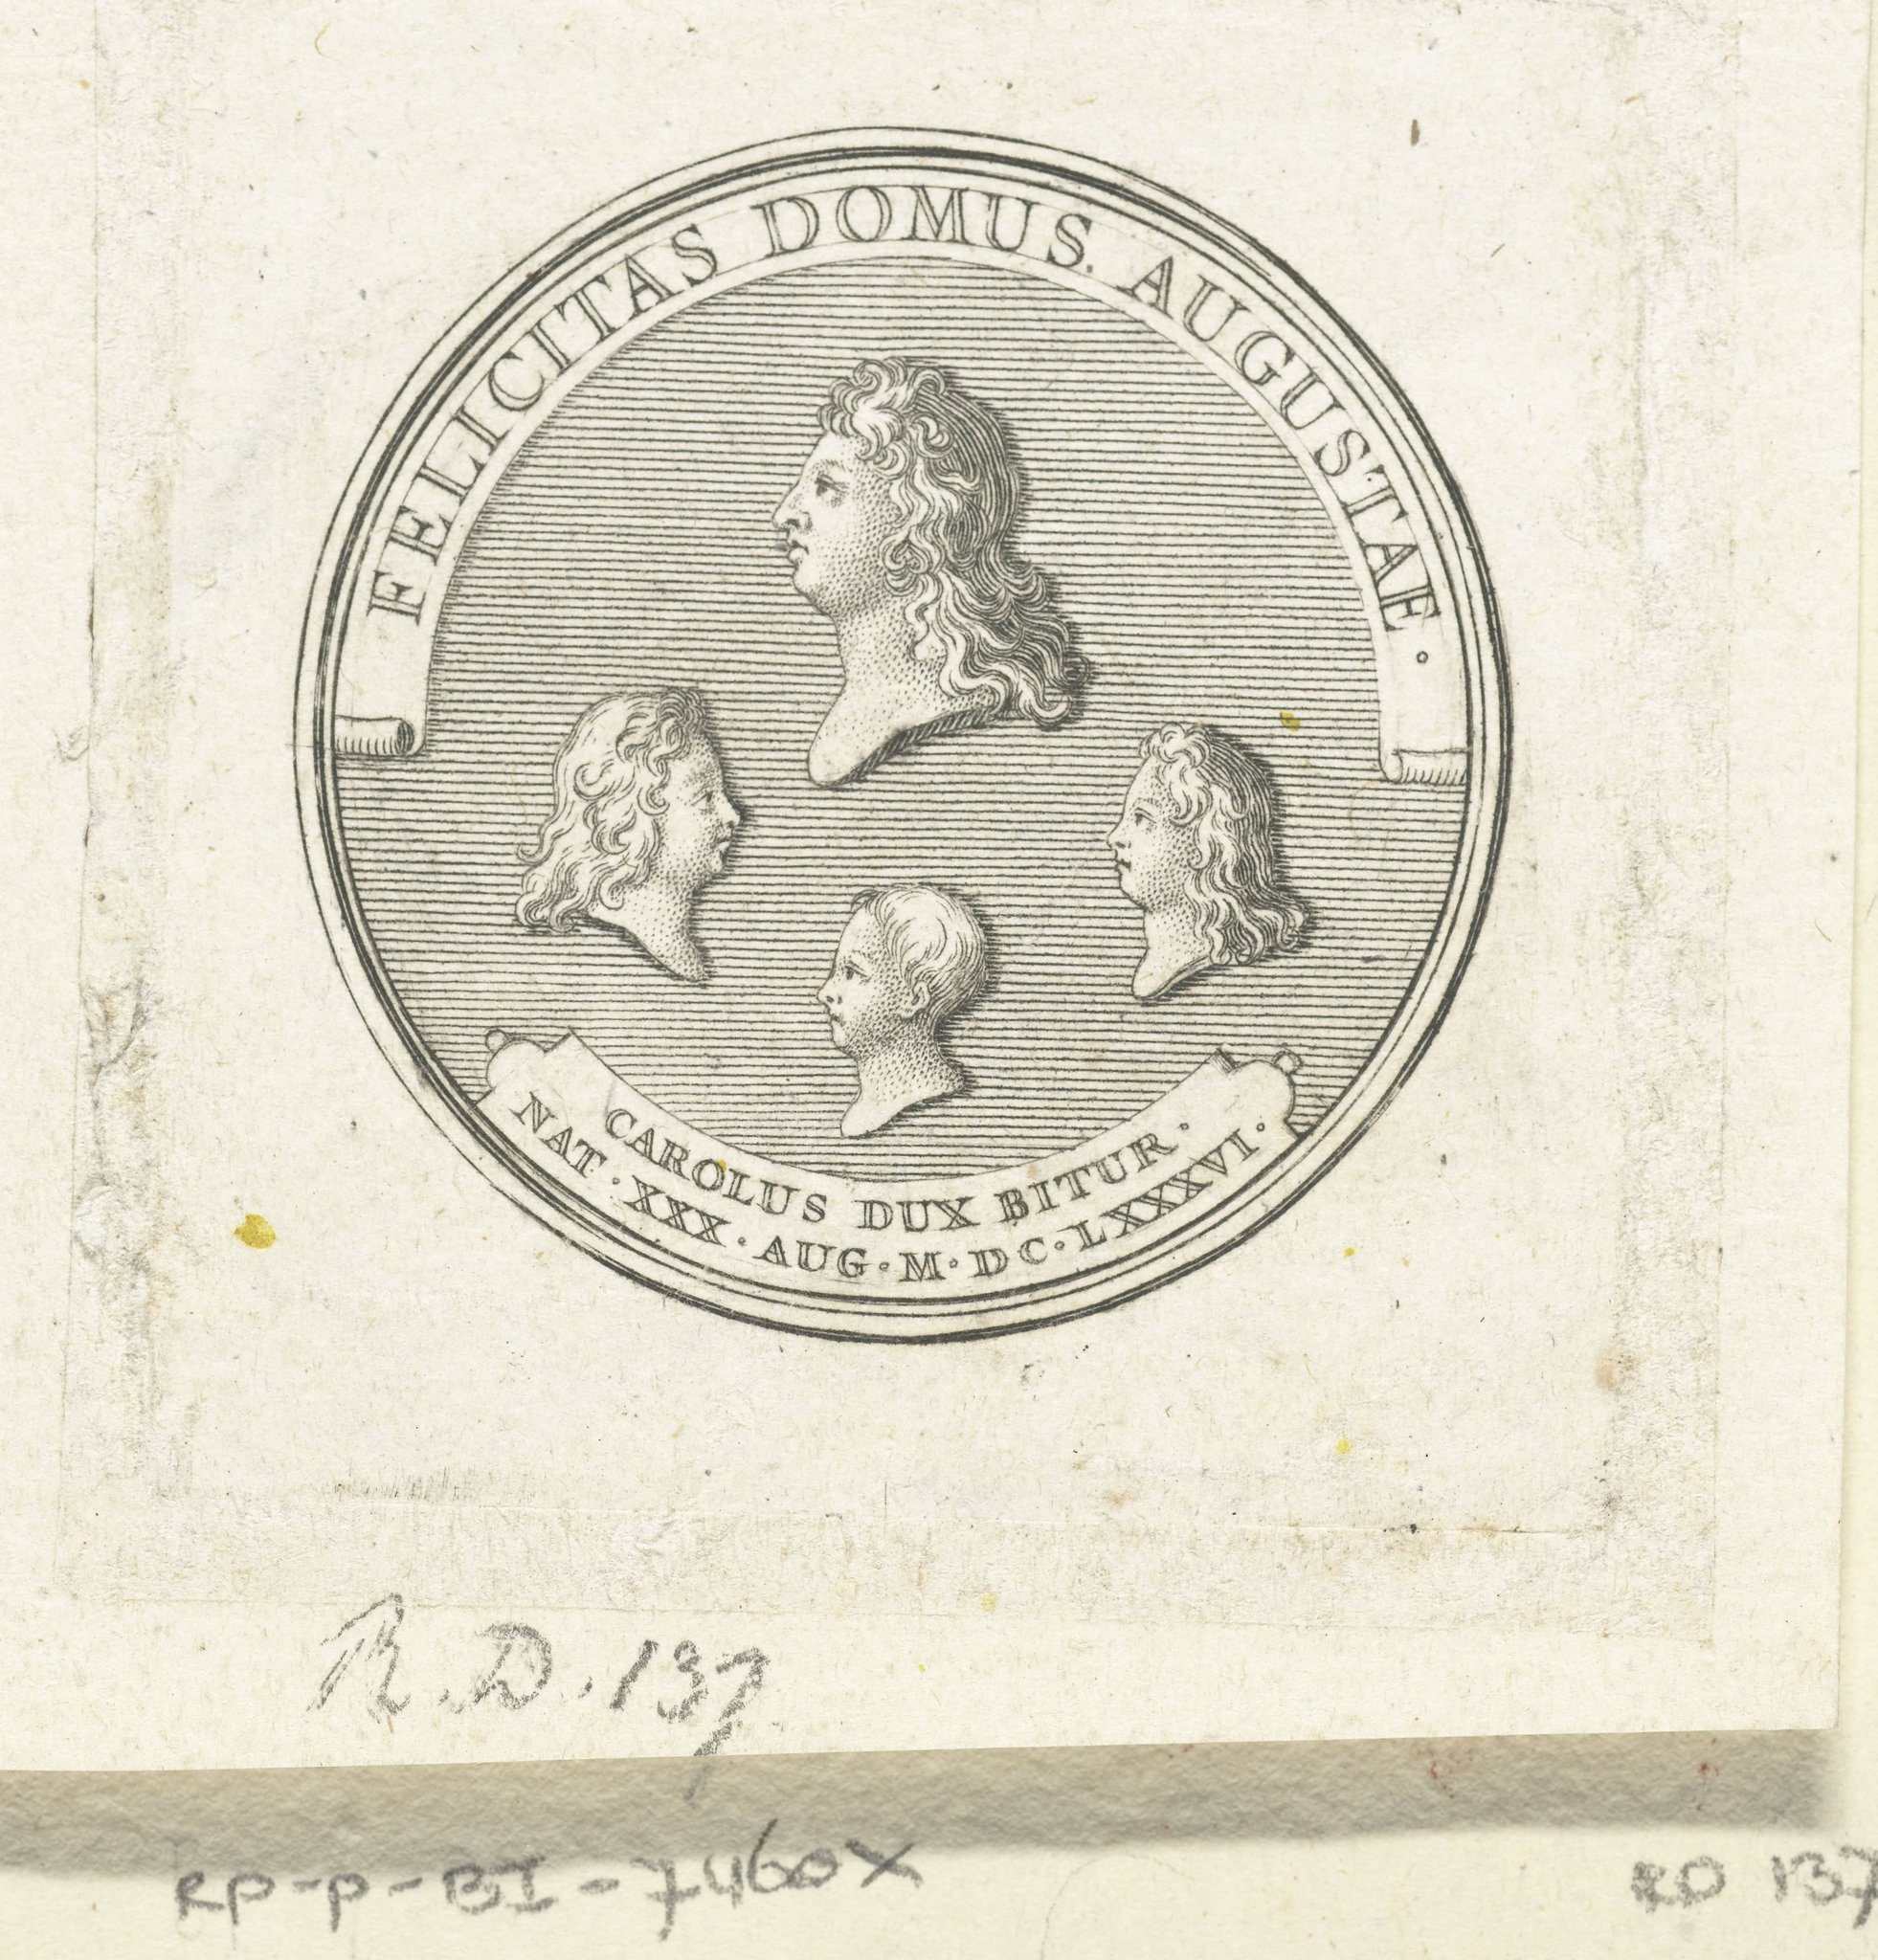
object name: print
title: Penning met vier bustes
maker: gerard edelinck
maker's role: print maker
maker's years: 1640-1707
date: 1702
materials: paper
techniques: engraving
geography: paris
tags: lodewijk van frankrijk (hertog van bourgondië), dauphin van frankrijk lodewijk, filips v (koning van spanje)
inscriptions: collector's mark: Lugt 240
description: Achterkant van een penning met vier bustes en profil. De bovenste is Lodewijk van Frankrijk (le Grand Dauphin), eronder zijn drie zonen: Lodewijk, hertog van Bourgondië en Filips, hertog van Anjou, elkaar aankijkend; tussenin: Karel van Frankrijk, hertog van Berry. De penning is gedateerd 30 augustus 1686.